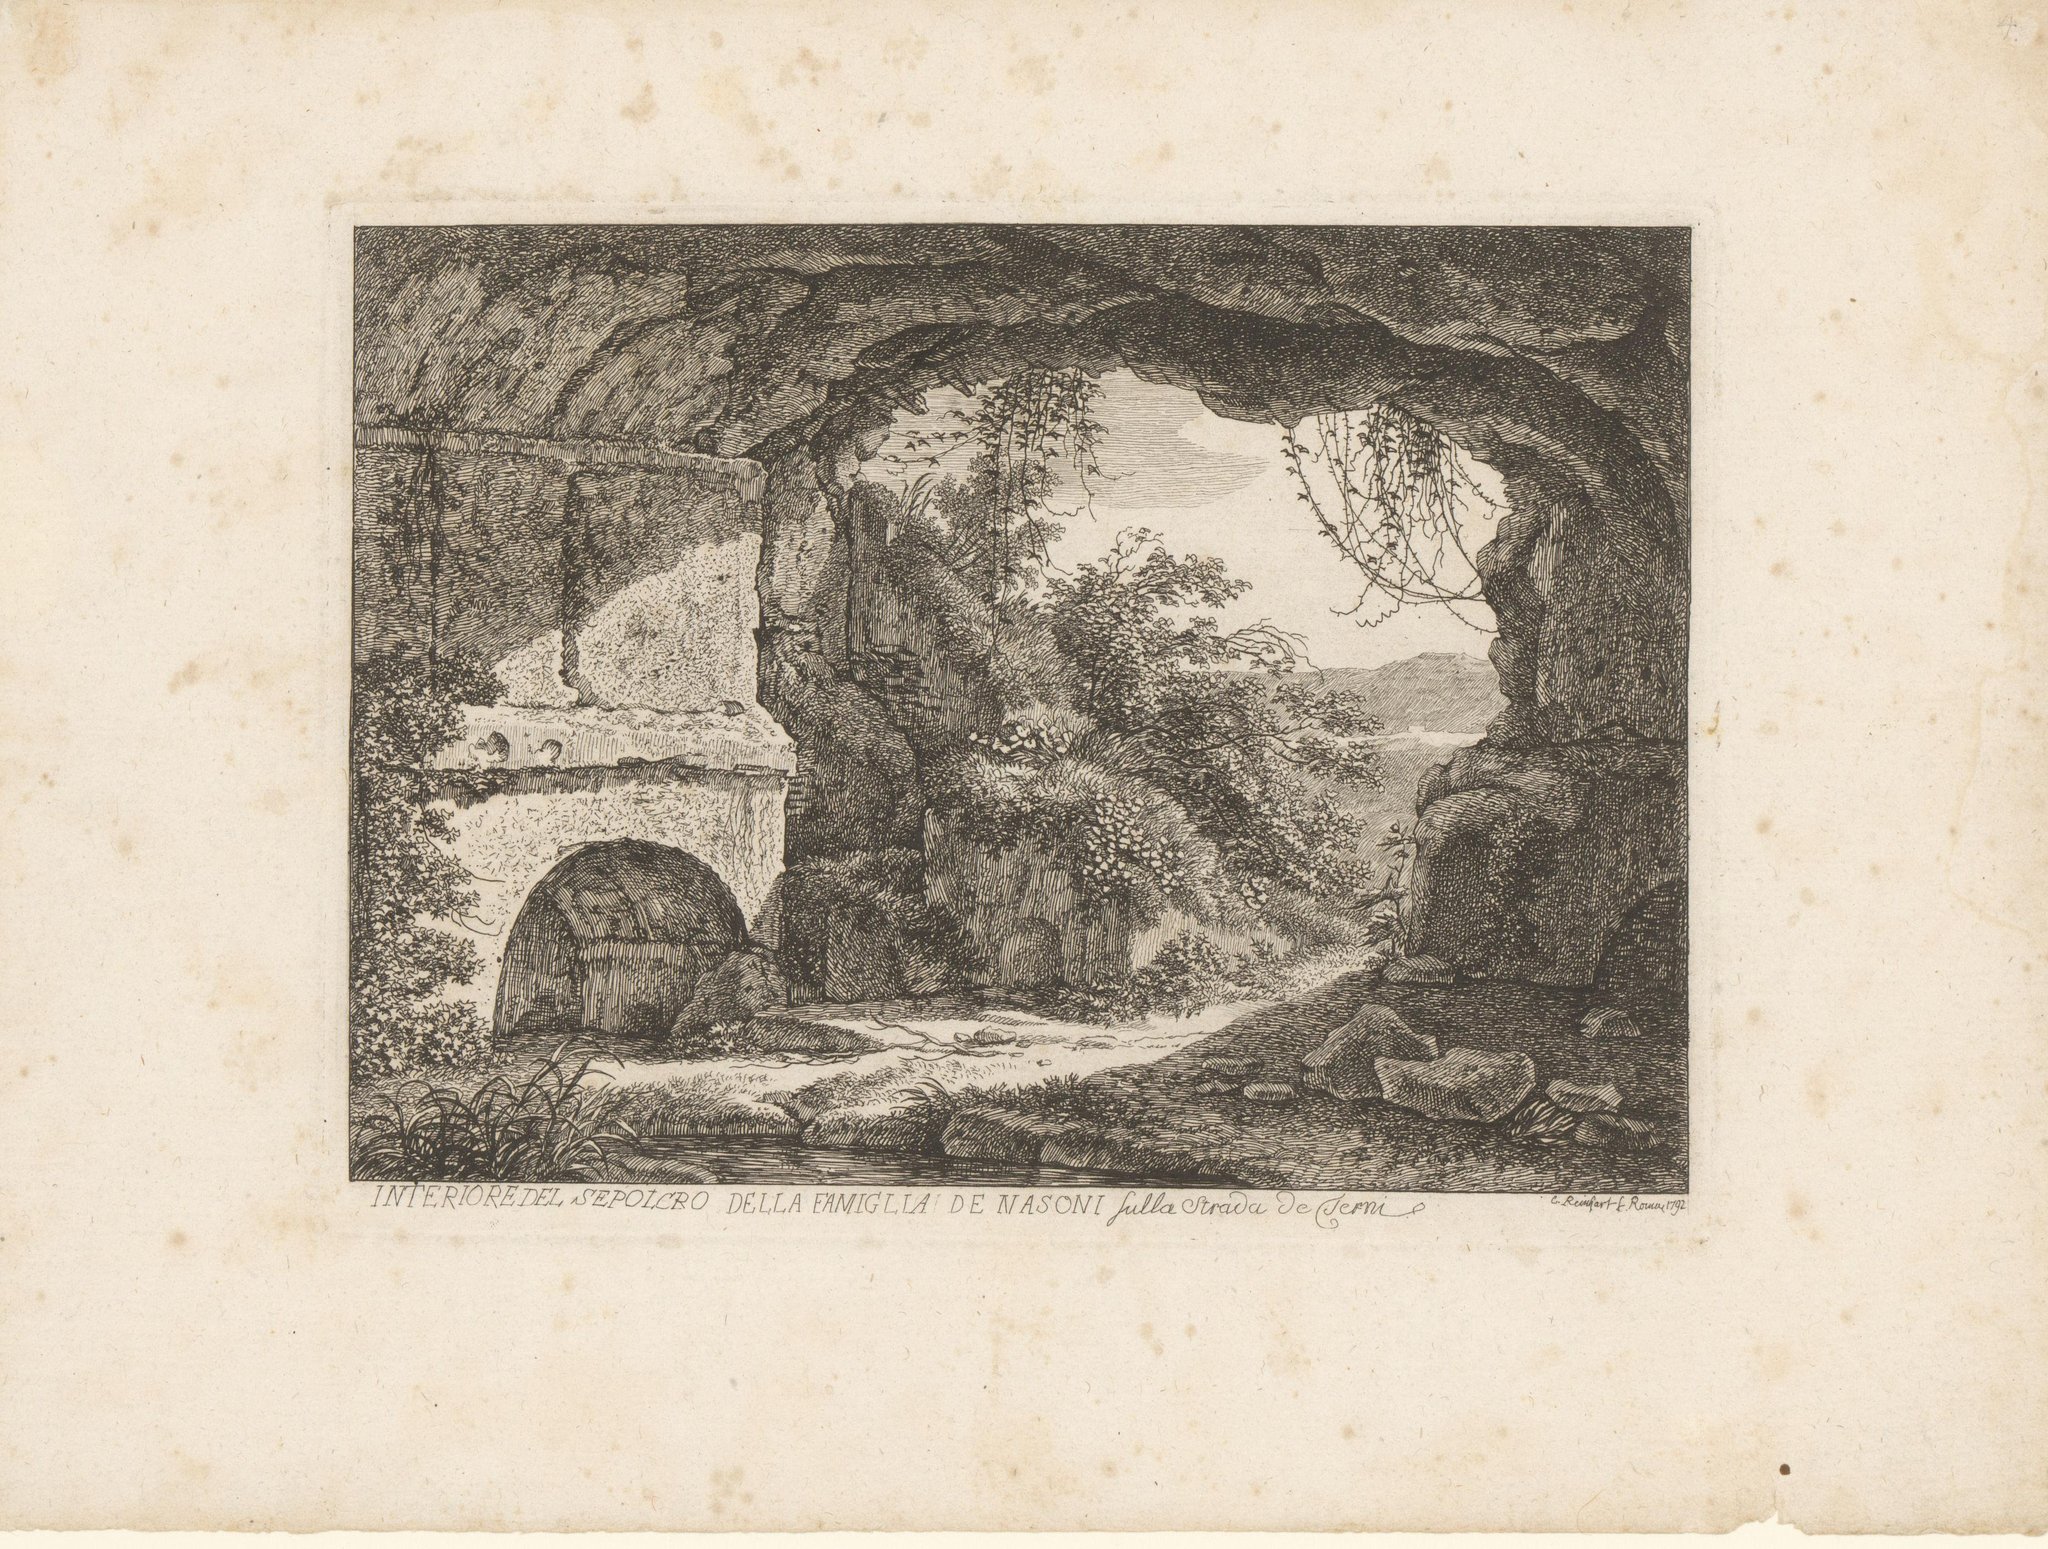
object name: print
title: Mahlerisch-radirte Prospecte von Italien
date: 1792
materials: paper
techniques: etching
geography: nuremberg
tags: landscape with ruins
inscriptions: collector's mark: Lugt 3870, collector's mark: Lugt 2228, collector's mark: Lugt 2760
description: Behorend tot een serie van 72 'Mahlerisch-radirte Prospecte von Italien', waarvoor de kunstenaar 24 prenten maakte. Albert Christoph Dies (1755-1822) en Jacob Wilhelm Mechau (1745-1808) maakten eveneens 24 platen, in opdracht van Jean Fréderic Frauenholz. Vanaf 1792 verschenen telkens drie sets van twee prenten per kunstenaar. In 1798 werd de laatste set uitgegeven, waarna complete sets gebonden werden uitgegeven tot in 1875 (Nuerenberg: J.L. Lotzbeck). Zie: Schmid, F.C., A.C. Dies, J.W. Mechau und J.C. Reinhart 'Mahlerische radirte Prospecte von Italien' (...). Berlijn: s.n., 1991.